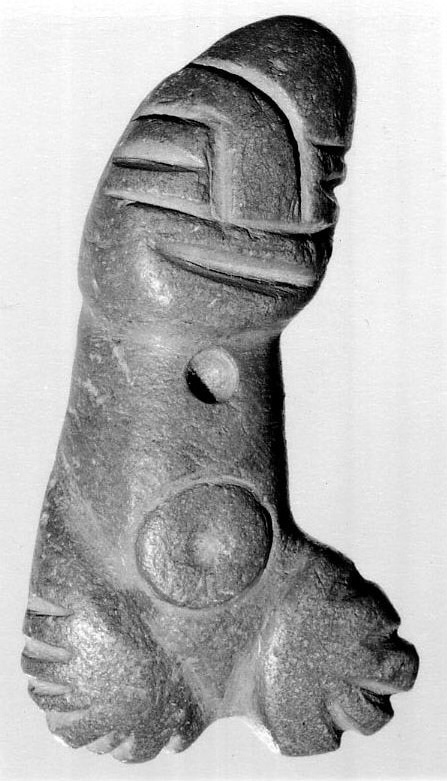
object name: talisman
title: Phallic Object, Possibly a Talisman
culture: japanese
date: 1000-300 BCE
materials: stone